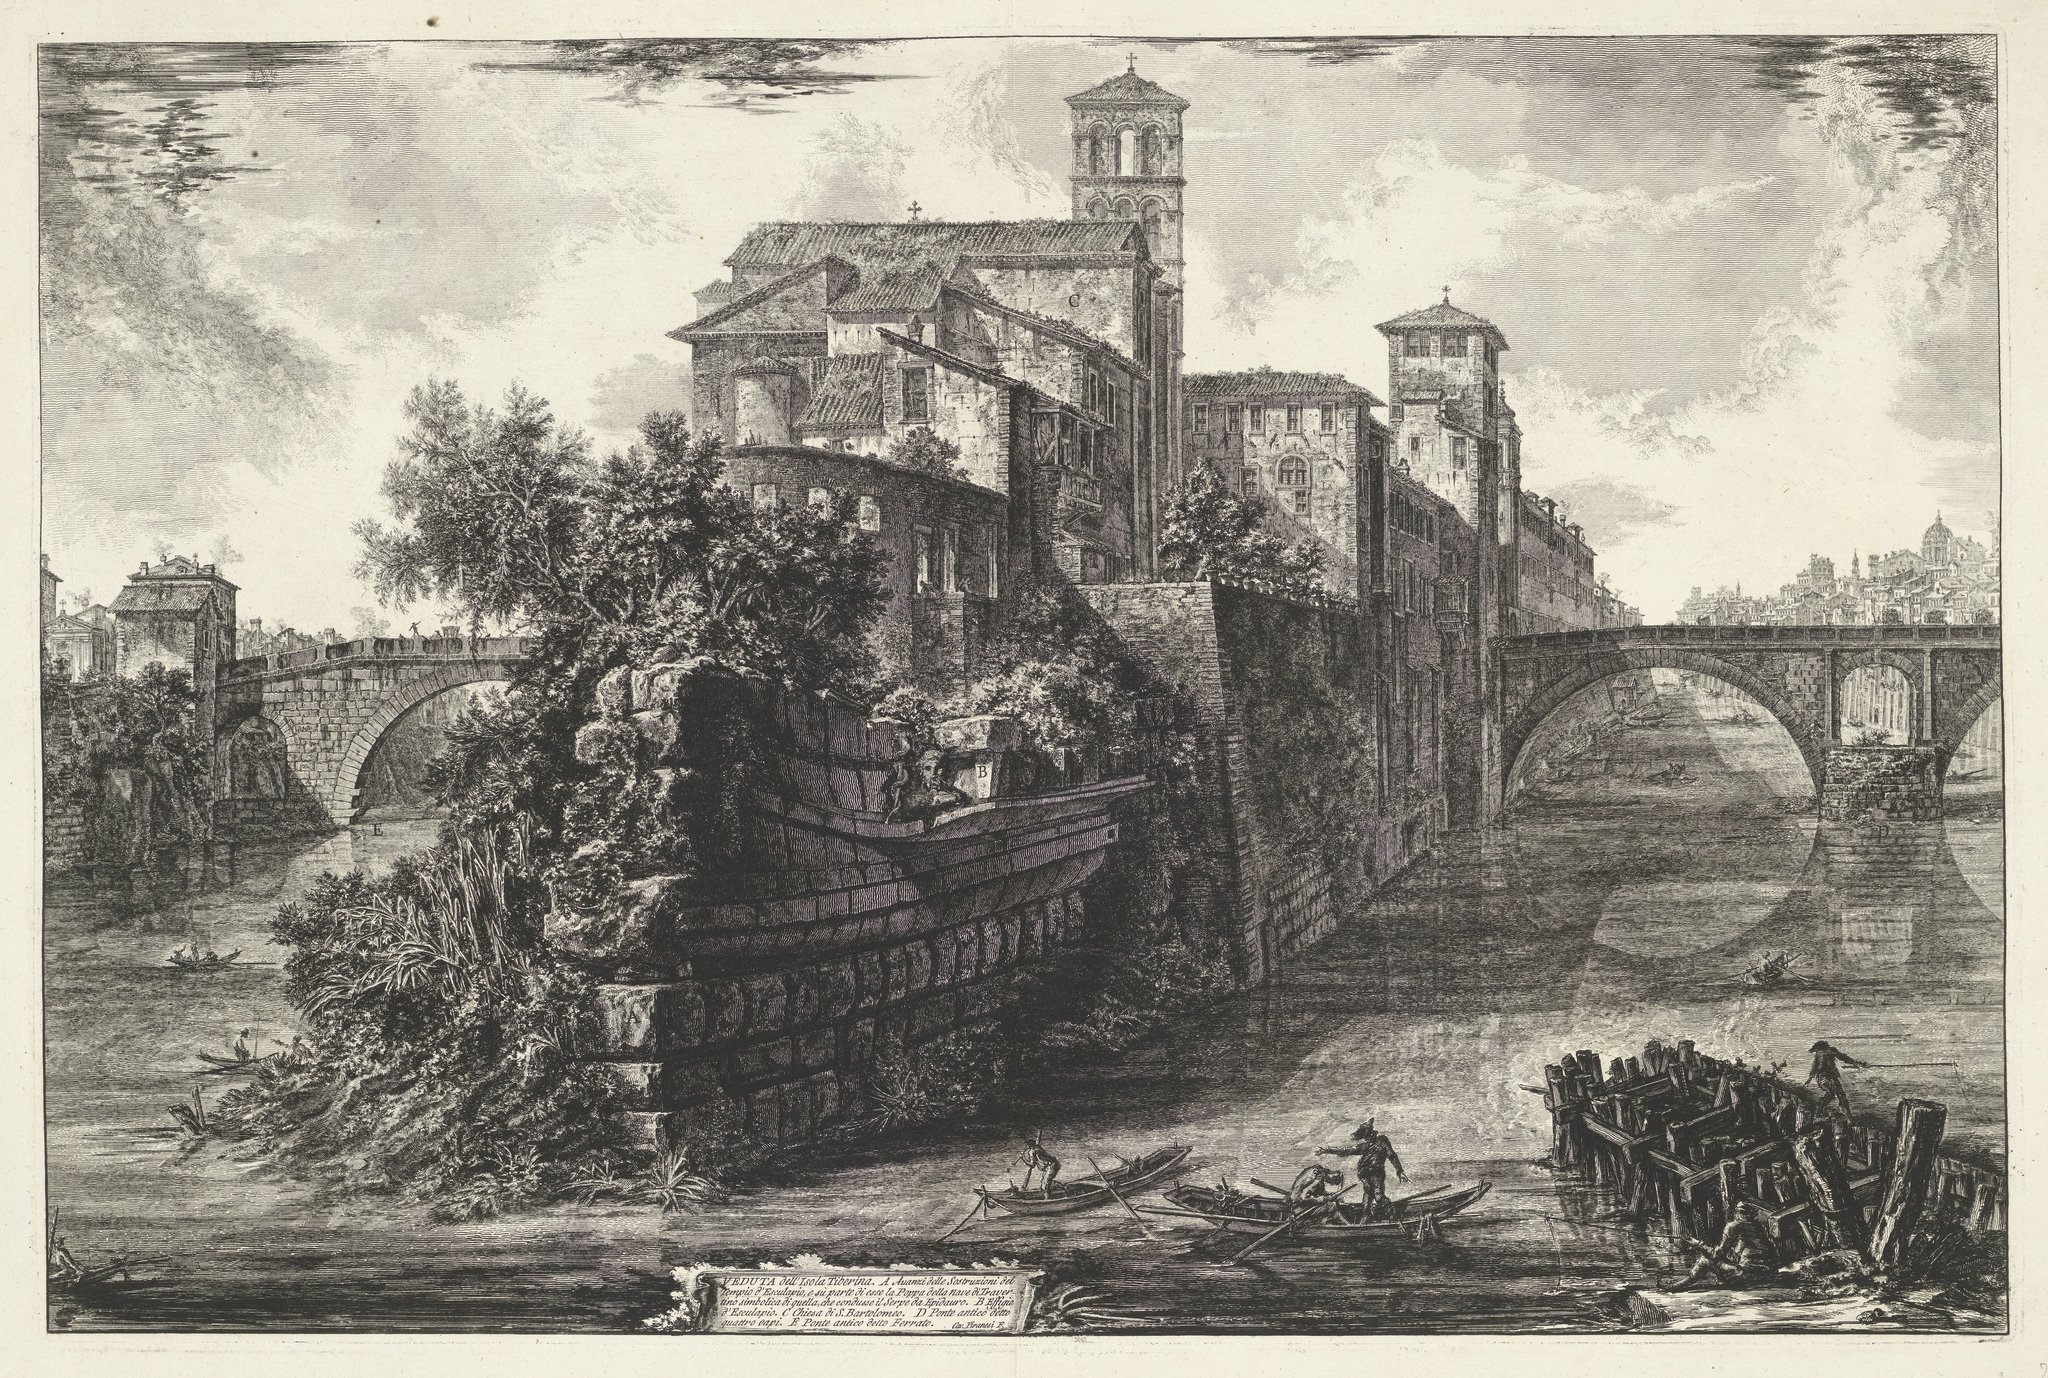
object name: print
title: Vedute di Roma disegnate ed incise da Giambattista Piranesi architetto Ve(nez)iano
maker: giovanni battista piranesi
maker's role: designer, draughtsman, print maker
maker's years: 1720-1778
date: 1748-1778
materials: paper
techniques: etching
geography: rome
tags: island, river, rome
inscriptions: collector's mark: Lugt 2228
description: Deze prent maakt deel uit van de serie 'Vedute di Roma'. Piranesi werkte aan deze 135 platen tellende serie tussen 1748 en zijn dood in 1778. Francesco Piranesi voegde later nog twee prenten toe aan de reeks van zijn vader.